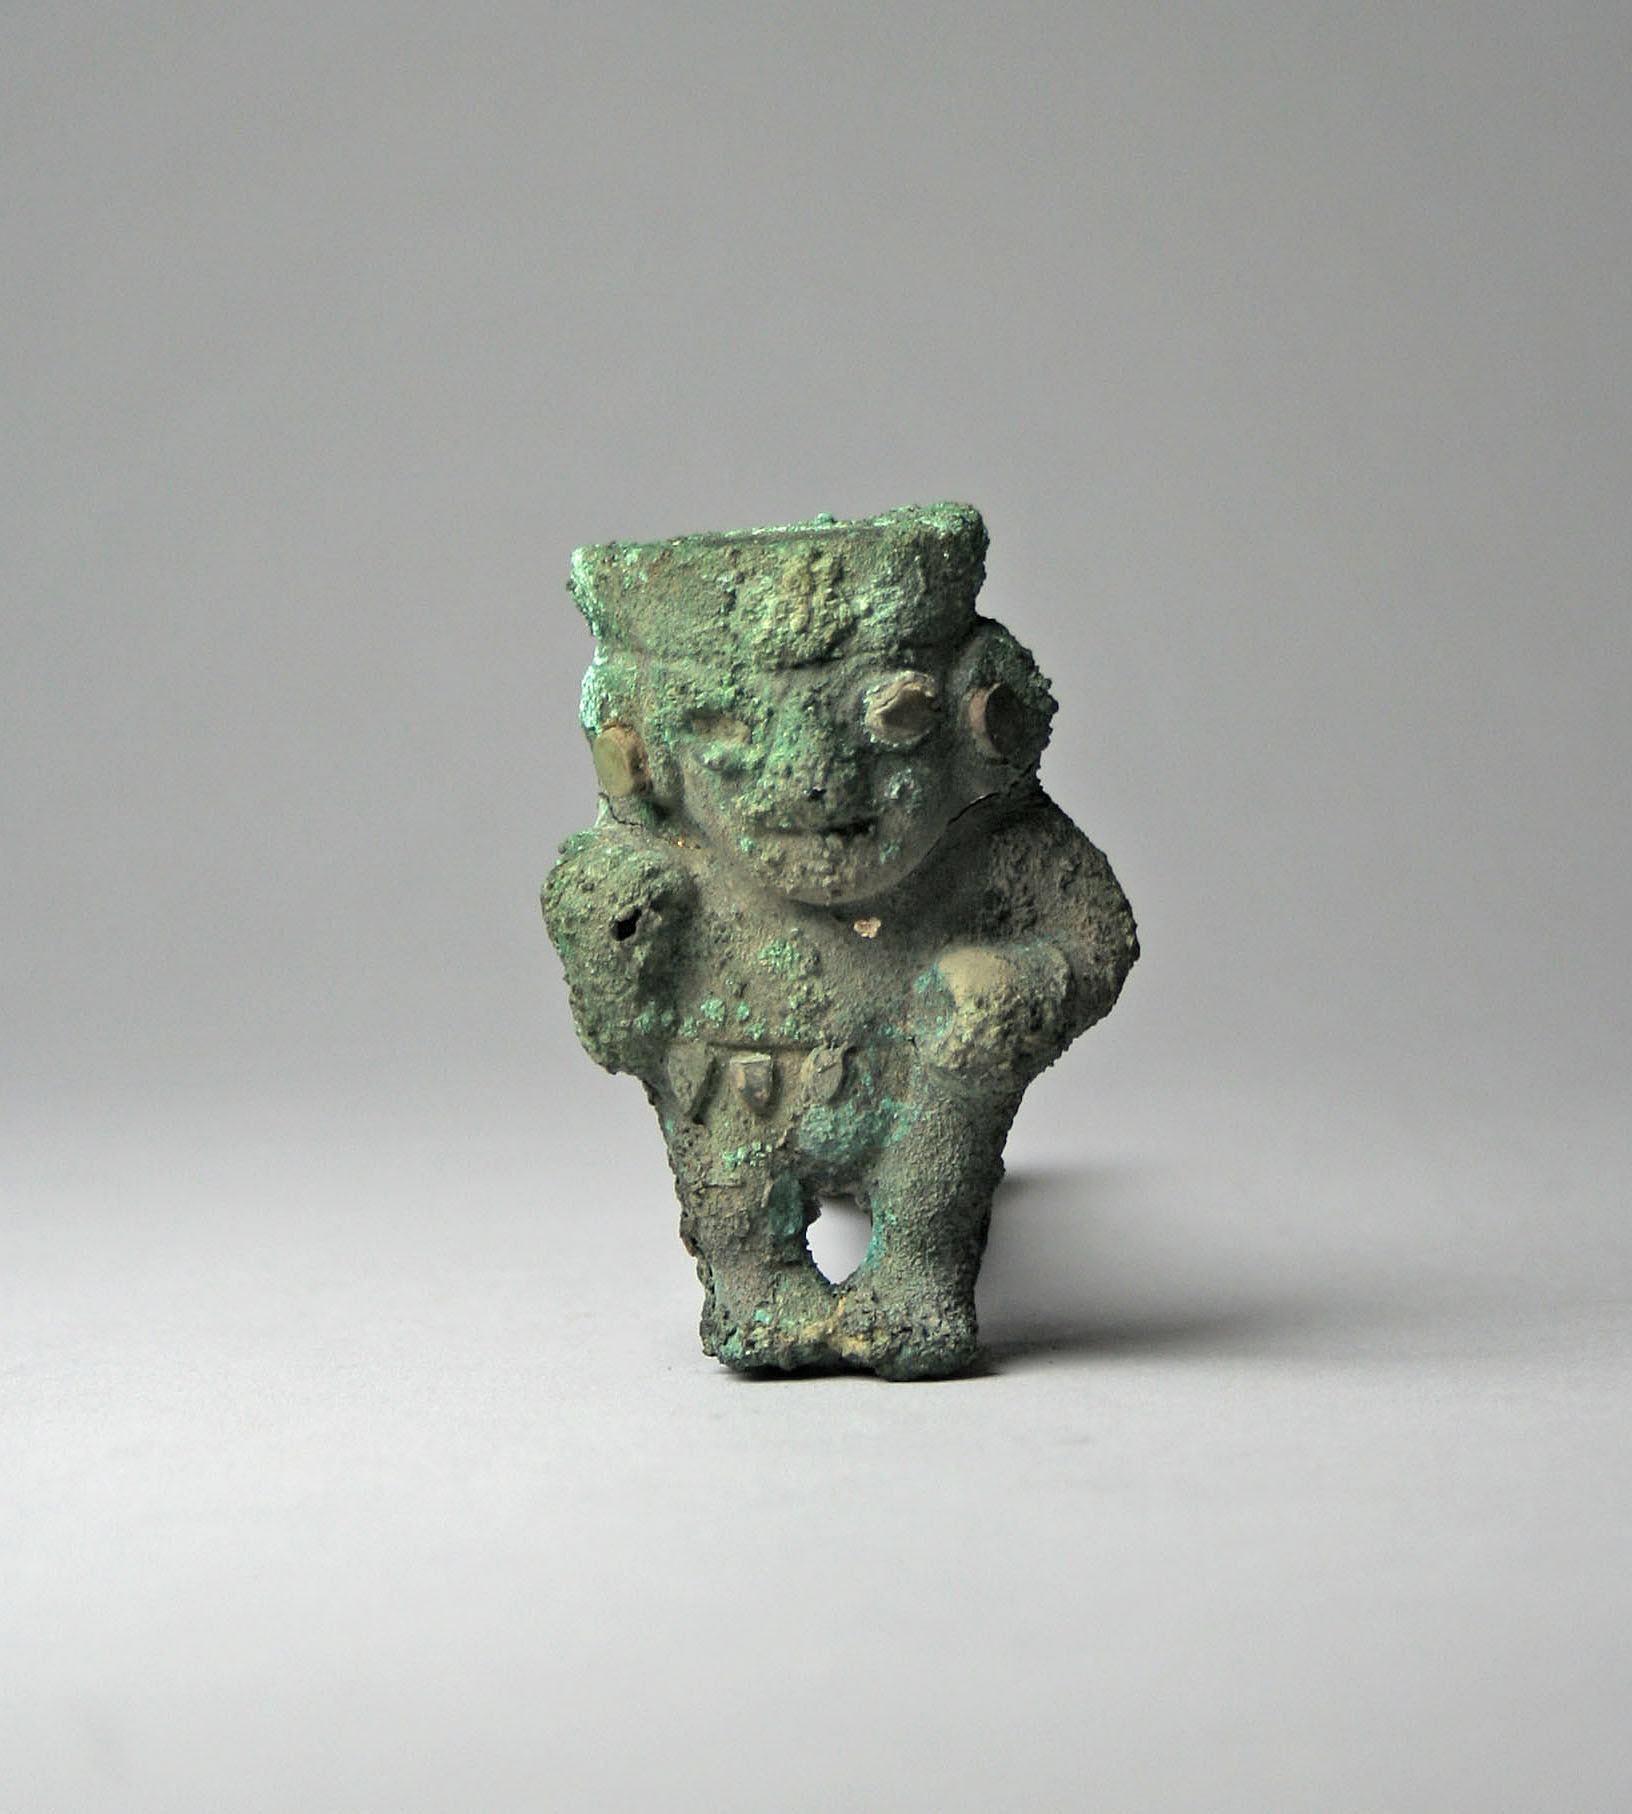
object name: ornament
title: Figure Ornament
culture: moche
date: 501-700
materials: gilt copper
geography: peru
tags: human figures